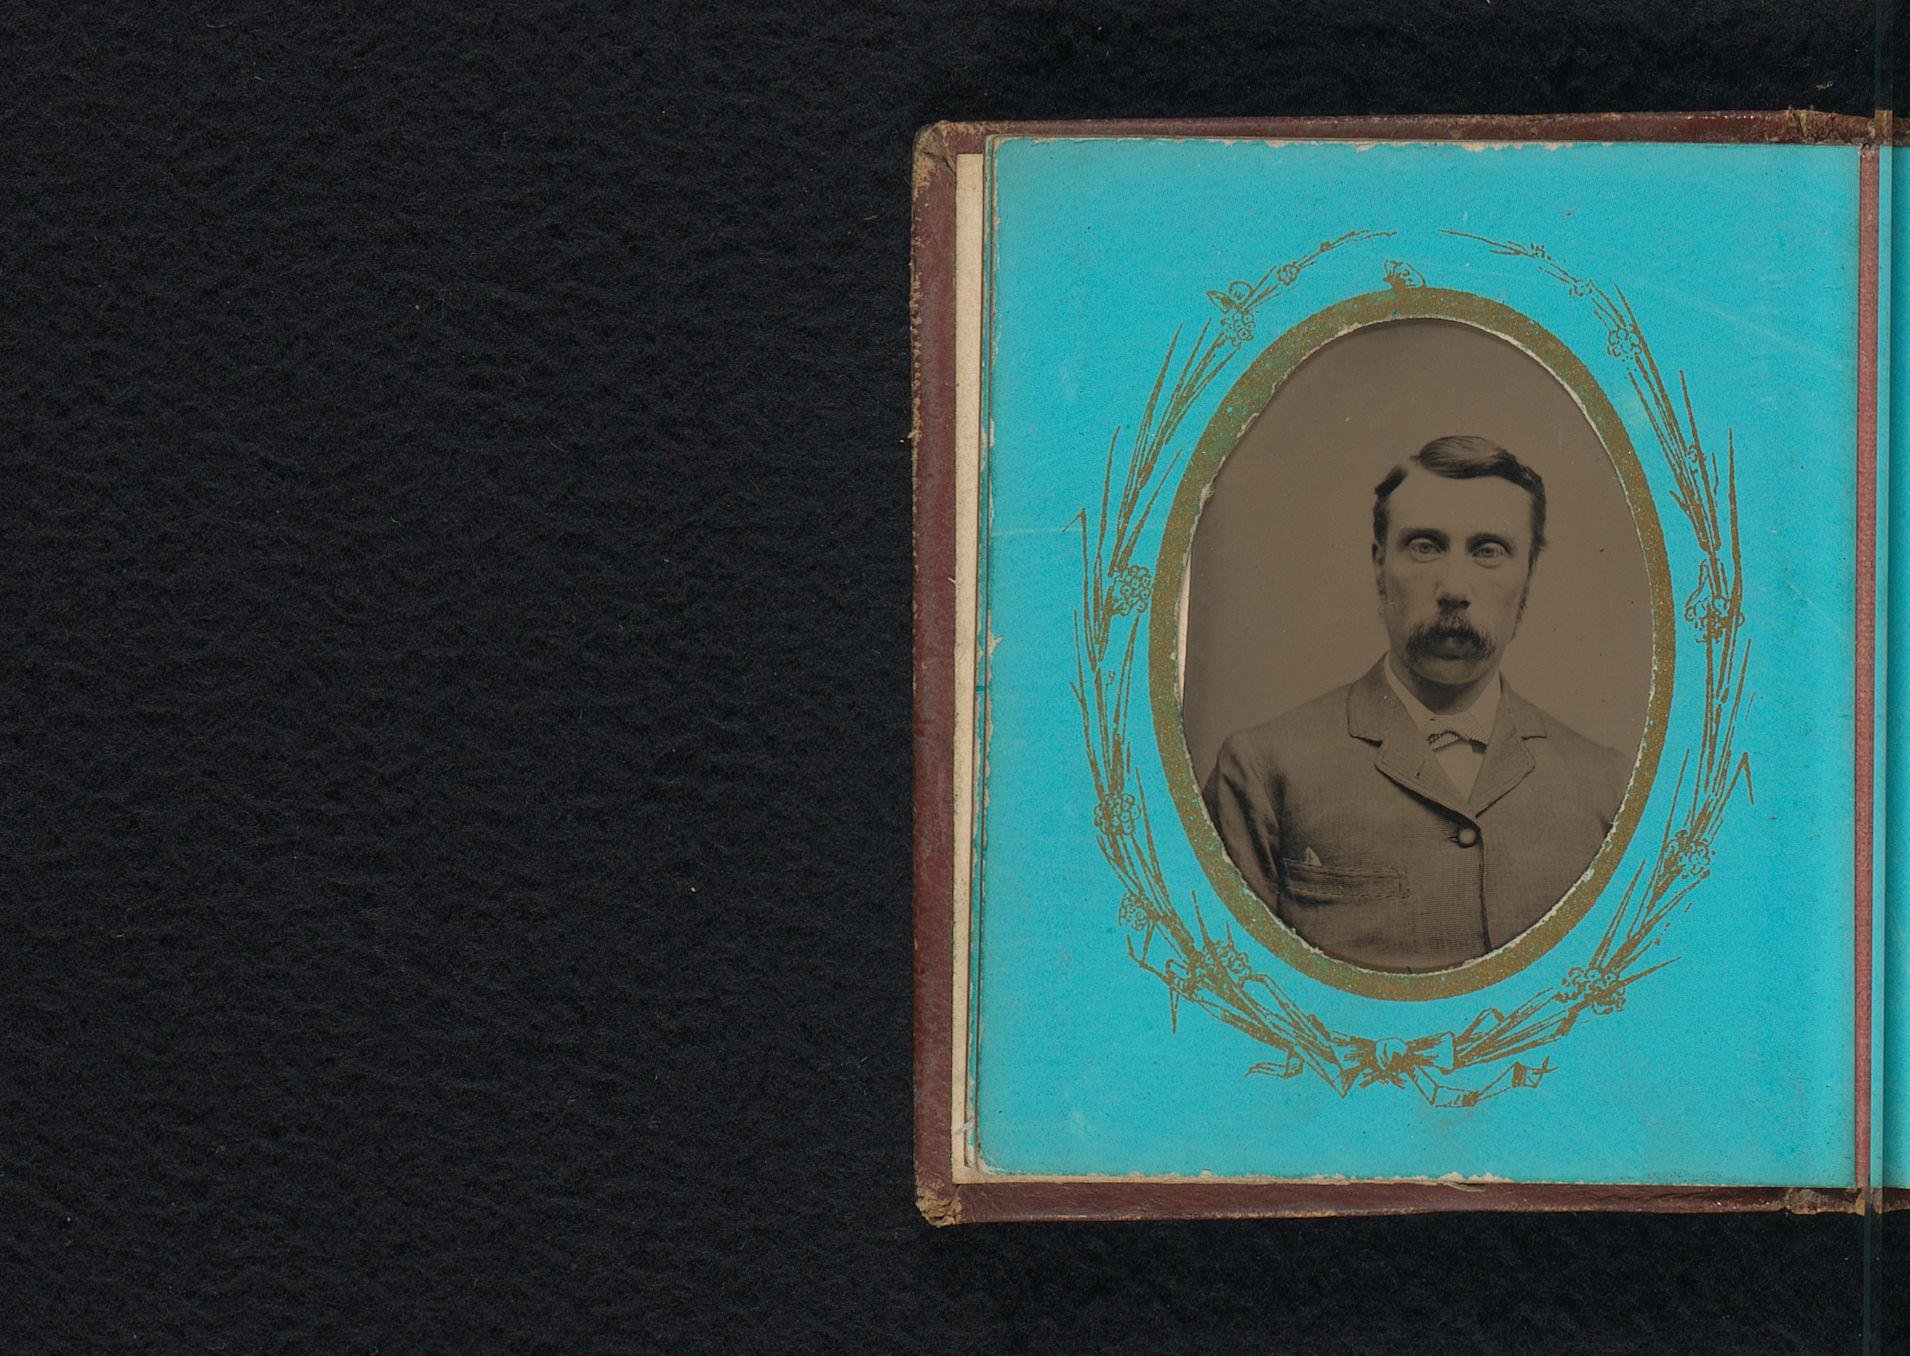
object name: photograph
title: Portret van een man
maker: Anonymous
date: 1855-1900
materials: iron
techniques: ferrotyping, hand coloring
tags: historical persons not known by name